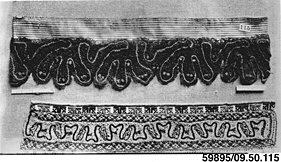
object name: fragment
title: Fragment of bobbin lace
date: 1801-1900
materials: gold, silk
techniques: lace